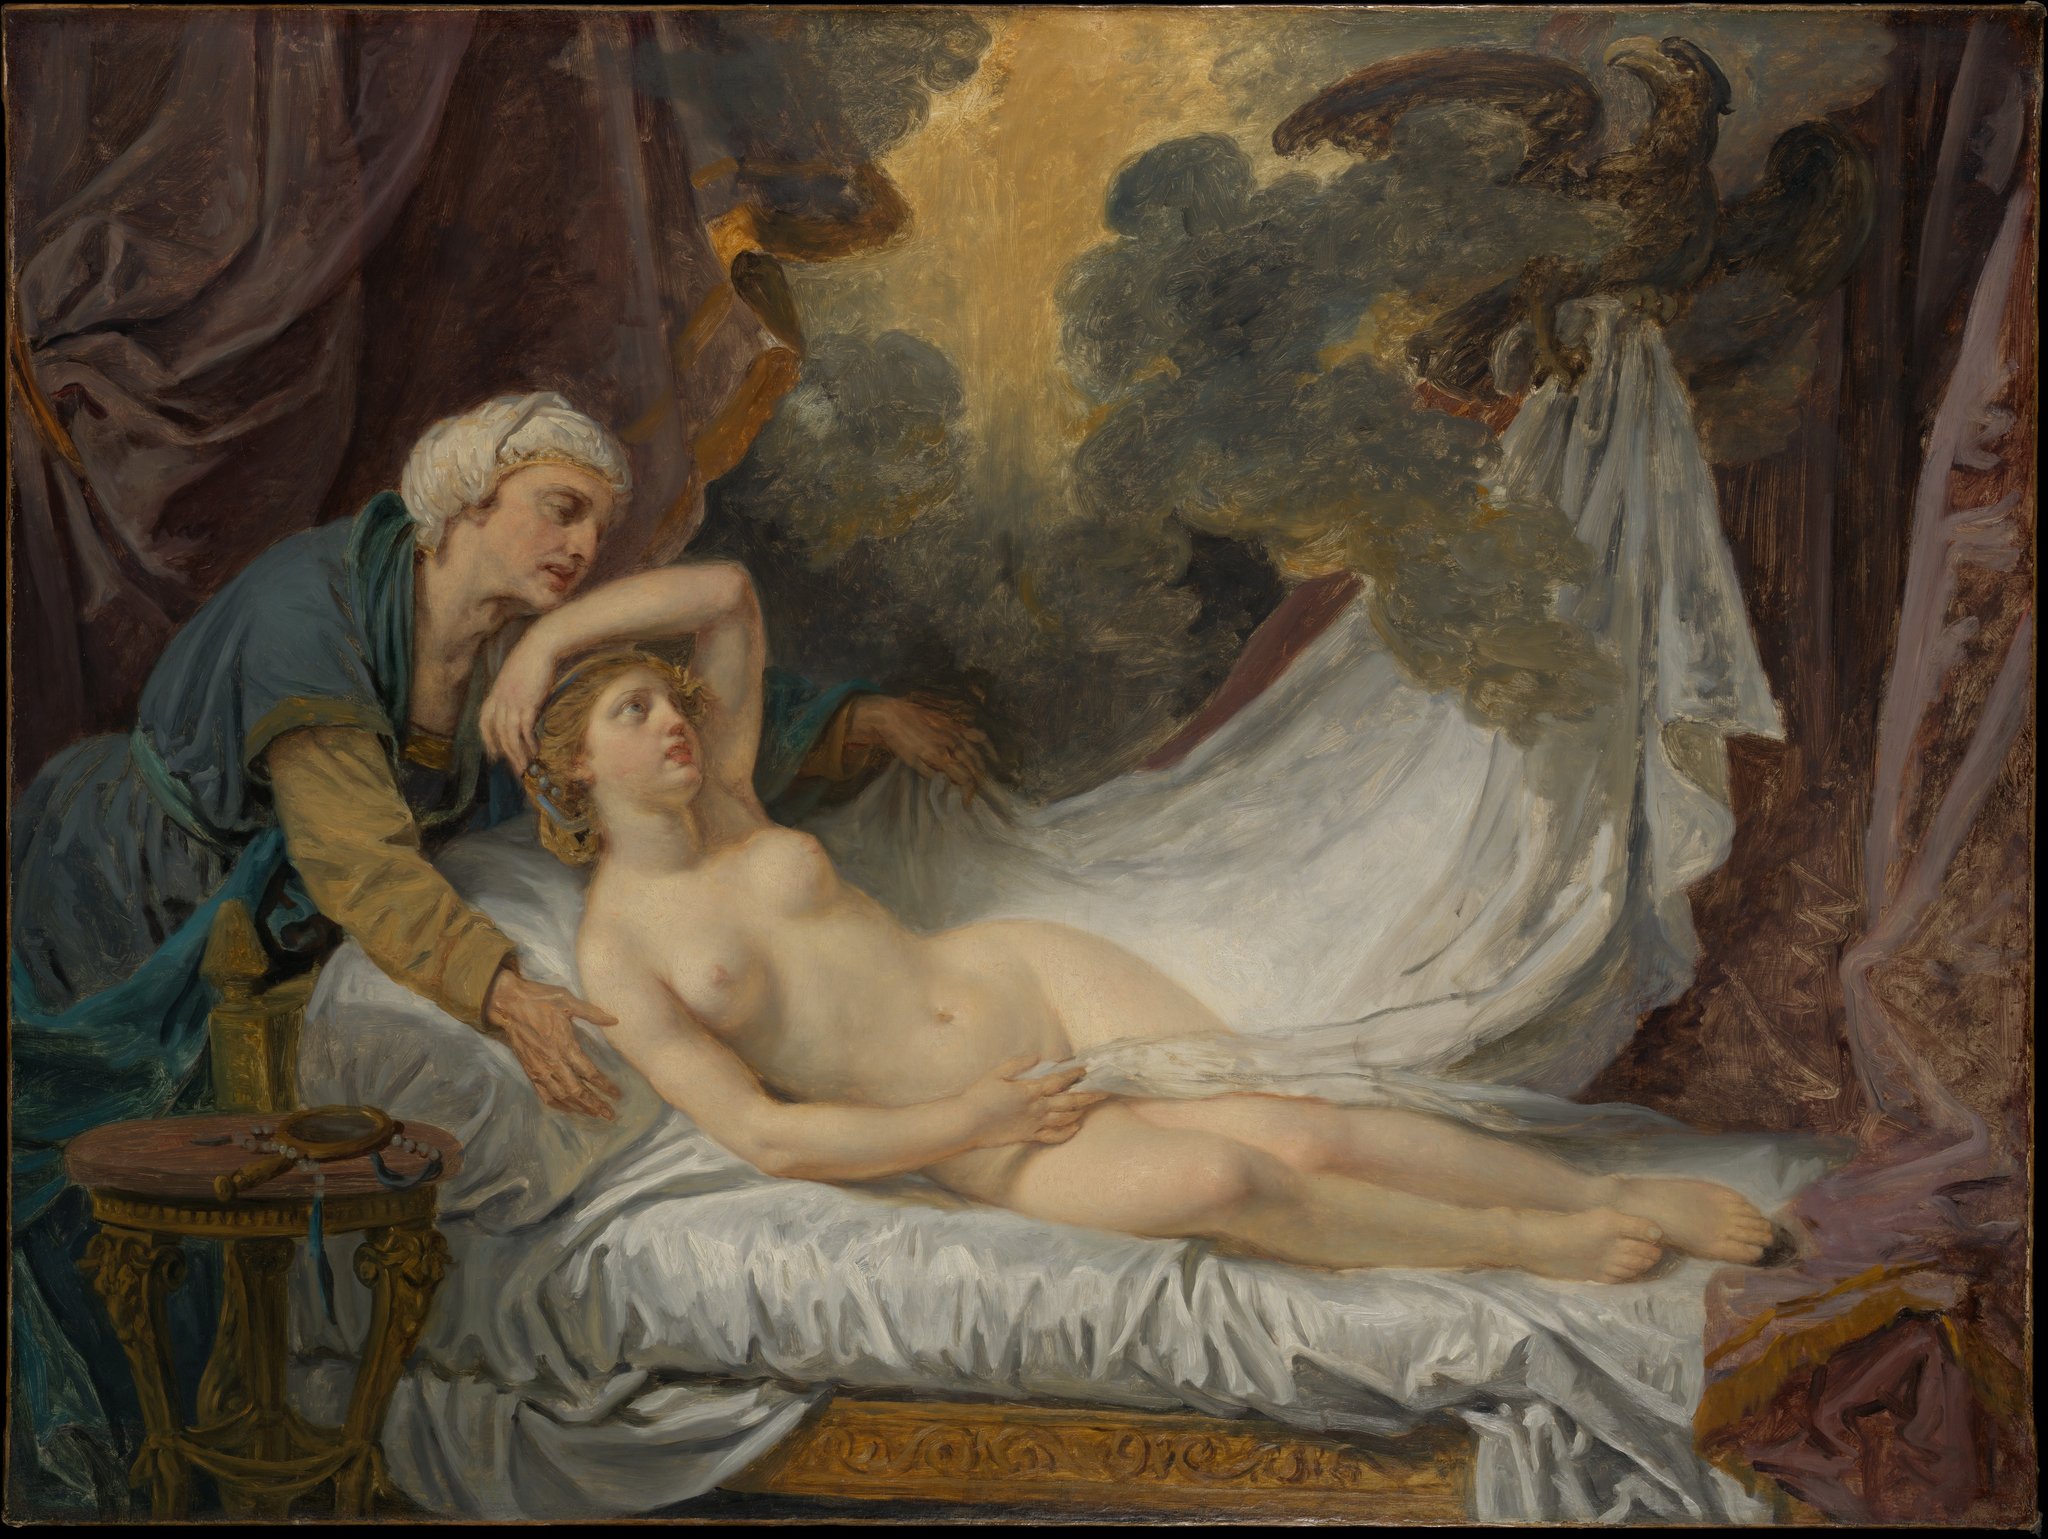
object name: painting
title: Aegina Visited by Jupiter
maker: jean-baptiste greuze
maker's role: artist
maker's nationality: french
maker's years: 1725-1805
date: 1767-1769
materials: canvas, oil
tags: eagles,female nudes,jupiter,beds